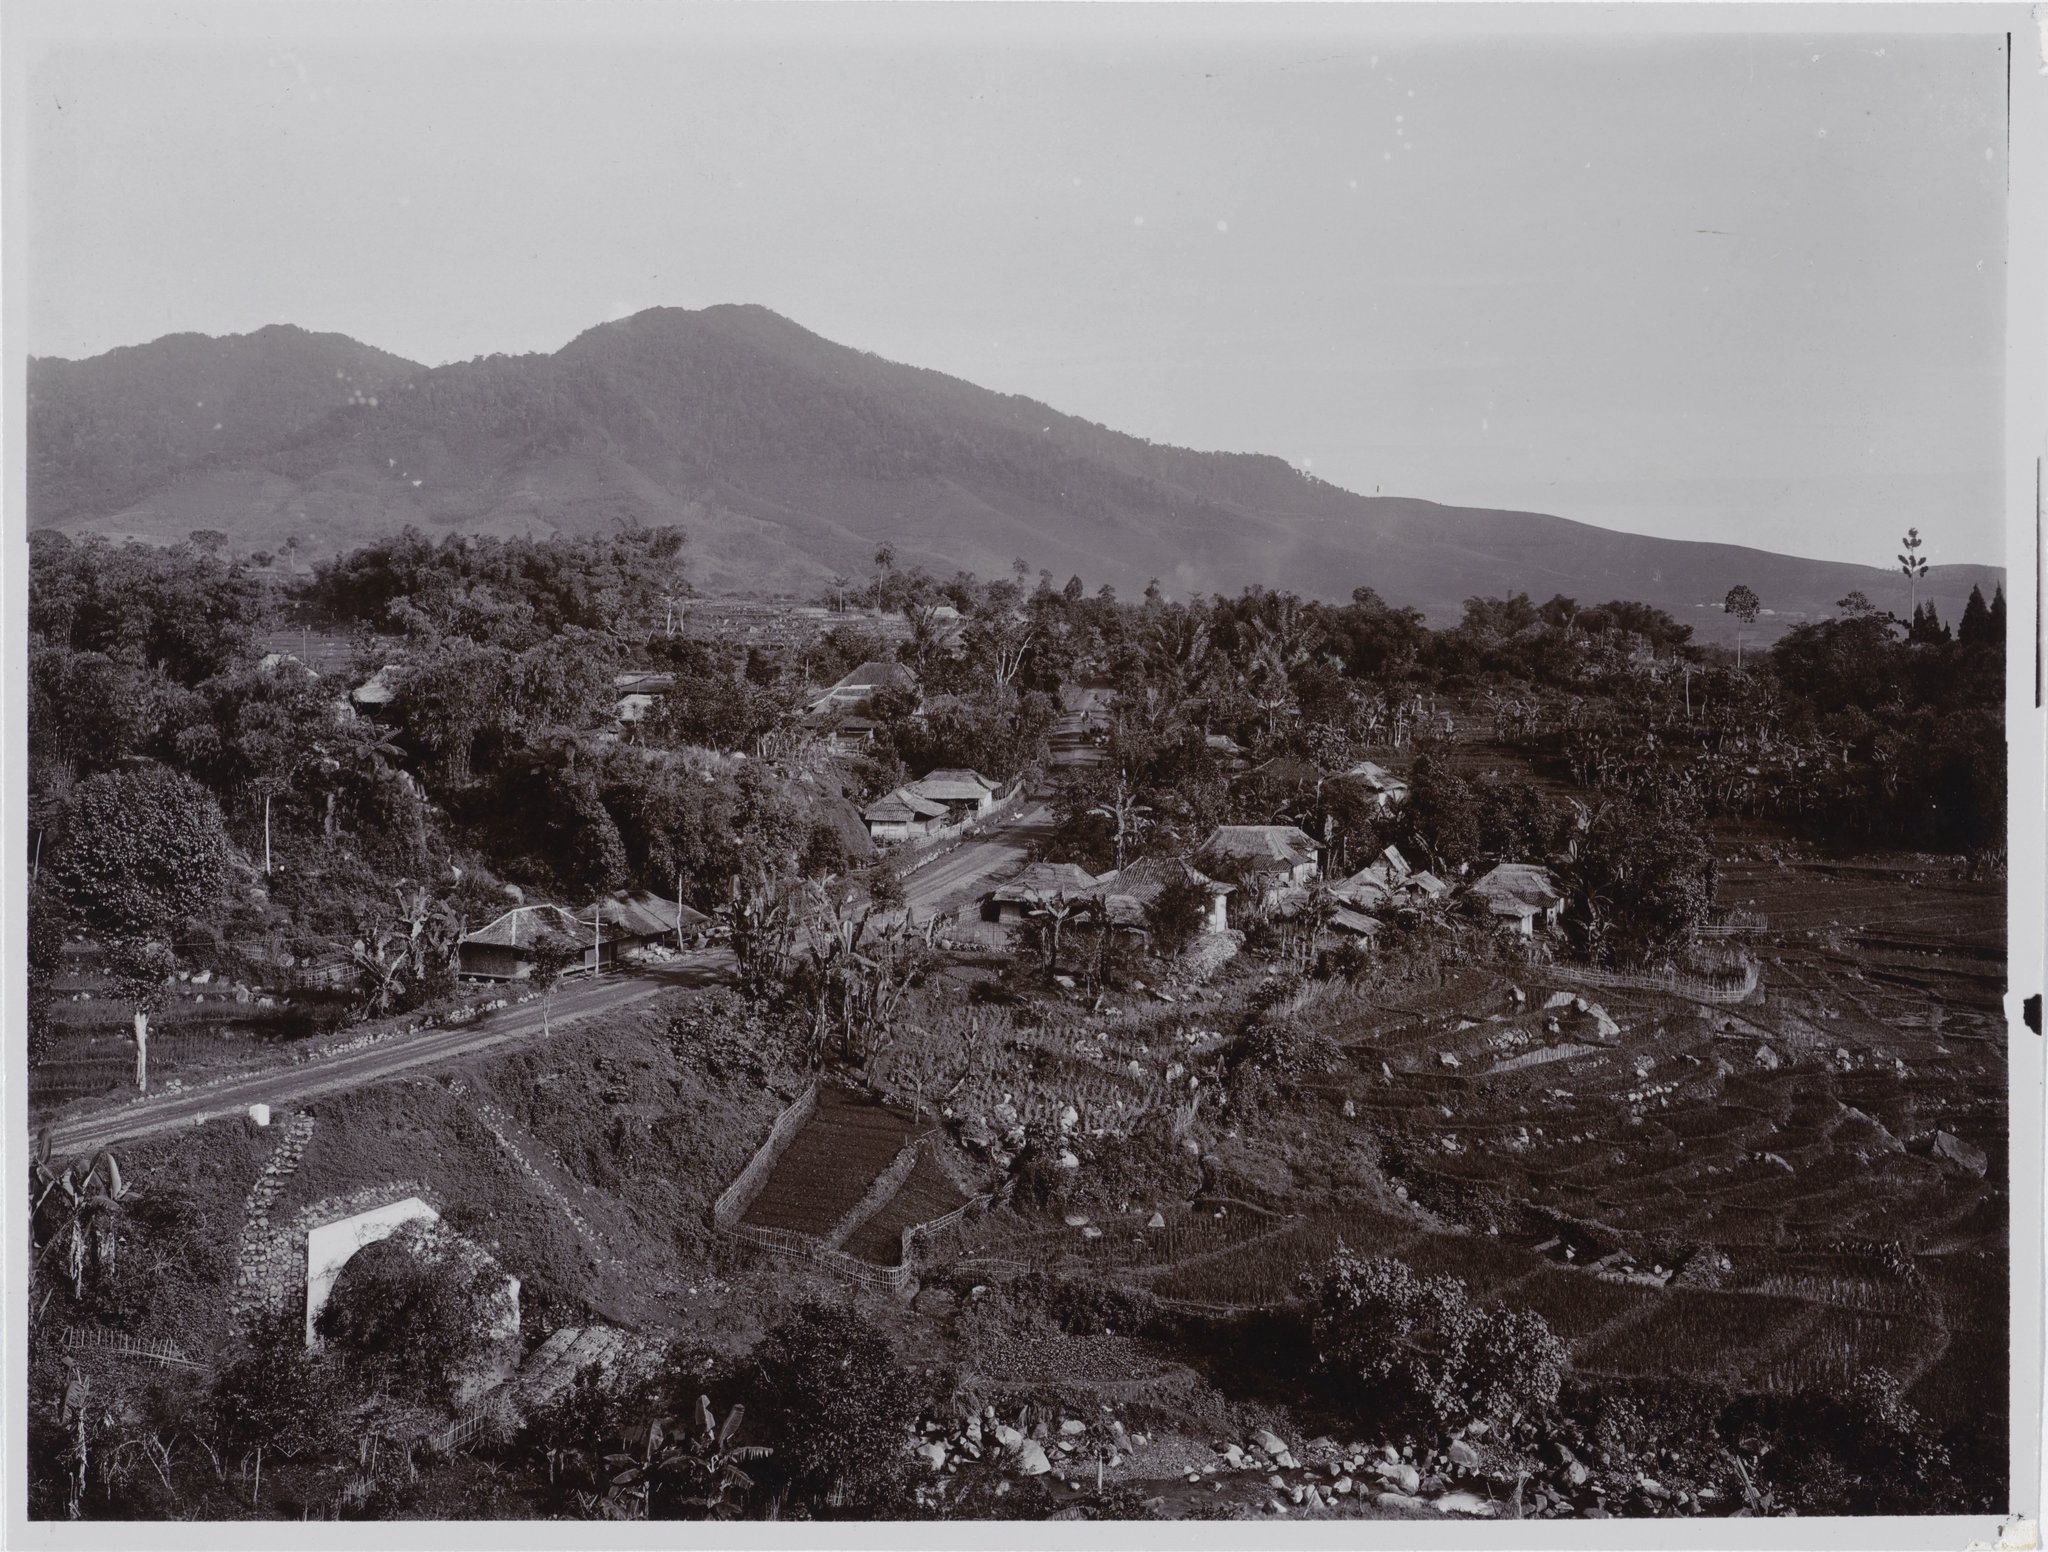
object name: stereograph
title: S 2 No 22. Landbouw. Grondbewerking. Ploegen.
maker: neville keasberry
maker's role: fotograaf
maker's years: 1866-1944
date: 1900-1935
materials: cardboard, paper, photographic support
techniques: albumen print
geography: malang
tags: agricultural implements: plough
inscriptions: signature: ‘Neville Keasberry, Malang (Java)’, inscription: ‘Stereoscopische Fotografie’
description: Het ploegen van het land met twee ploegen. Elke ploeg wordt voortgetrokken door twee runderen.